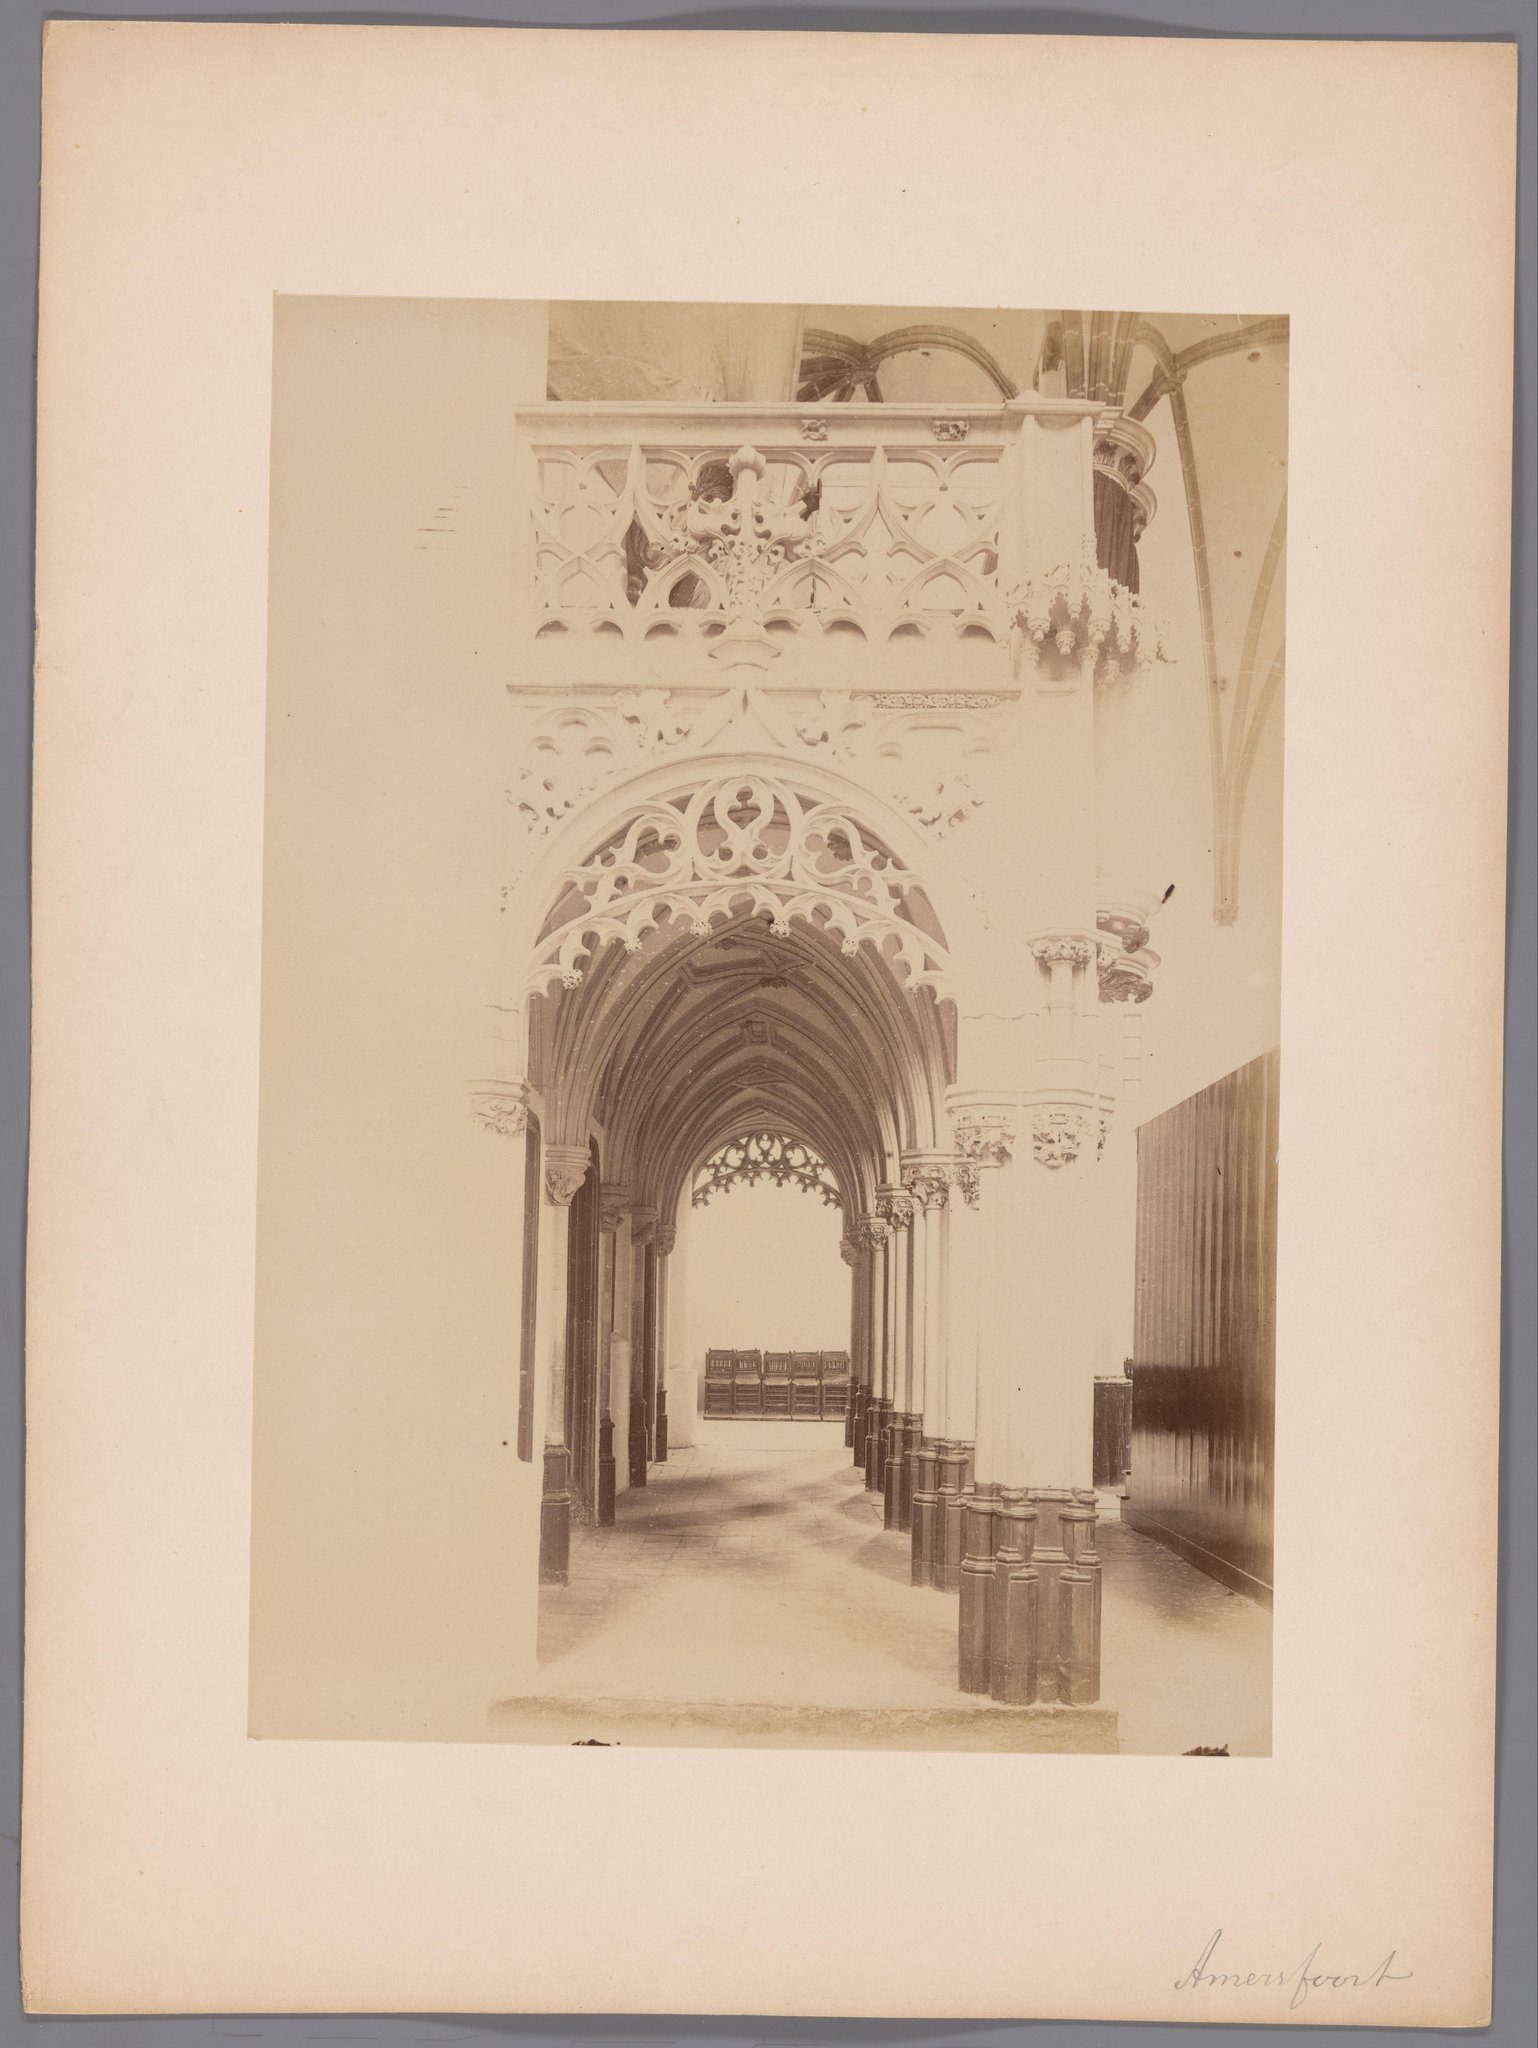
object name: photograph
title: Interieur van de Sint-Joriskerk te Amersfoort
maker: anoniem (monumentenzorg)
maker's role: fotograaf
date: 1891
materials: cardboard, photographic support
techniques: albumen print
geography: amersfoort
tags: interior of church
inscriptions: annotation: ‘Amersfoort S. Joriskerk Juli/ sept 1891’, annotation: ‘Amersfoort’